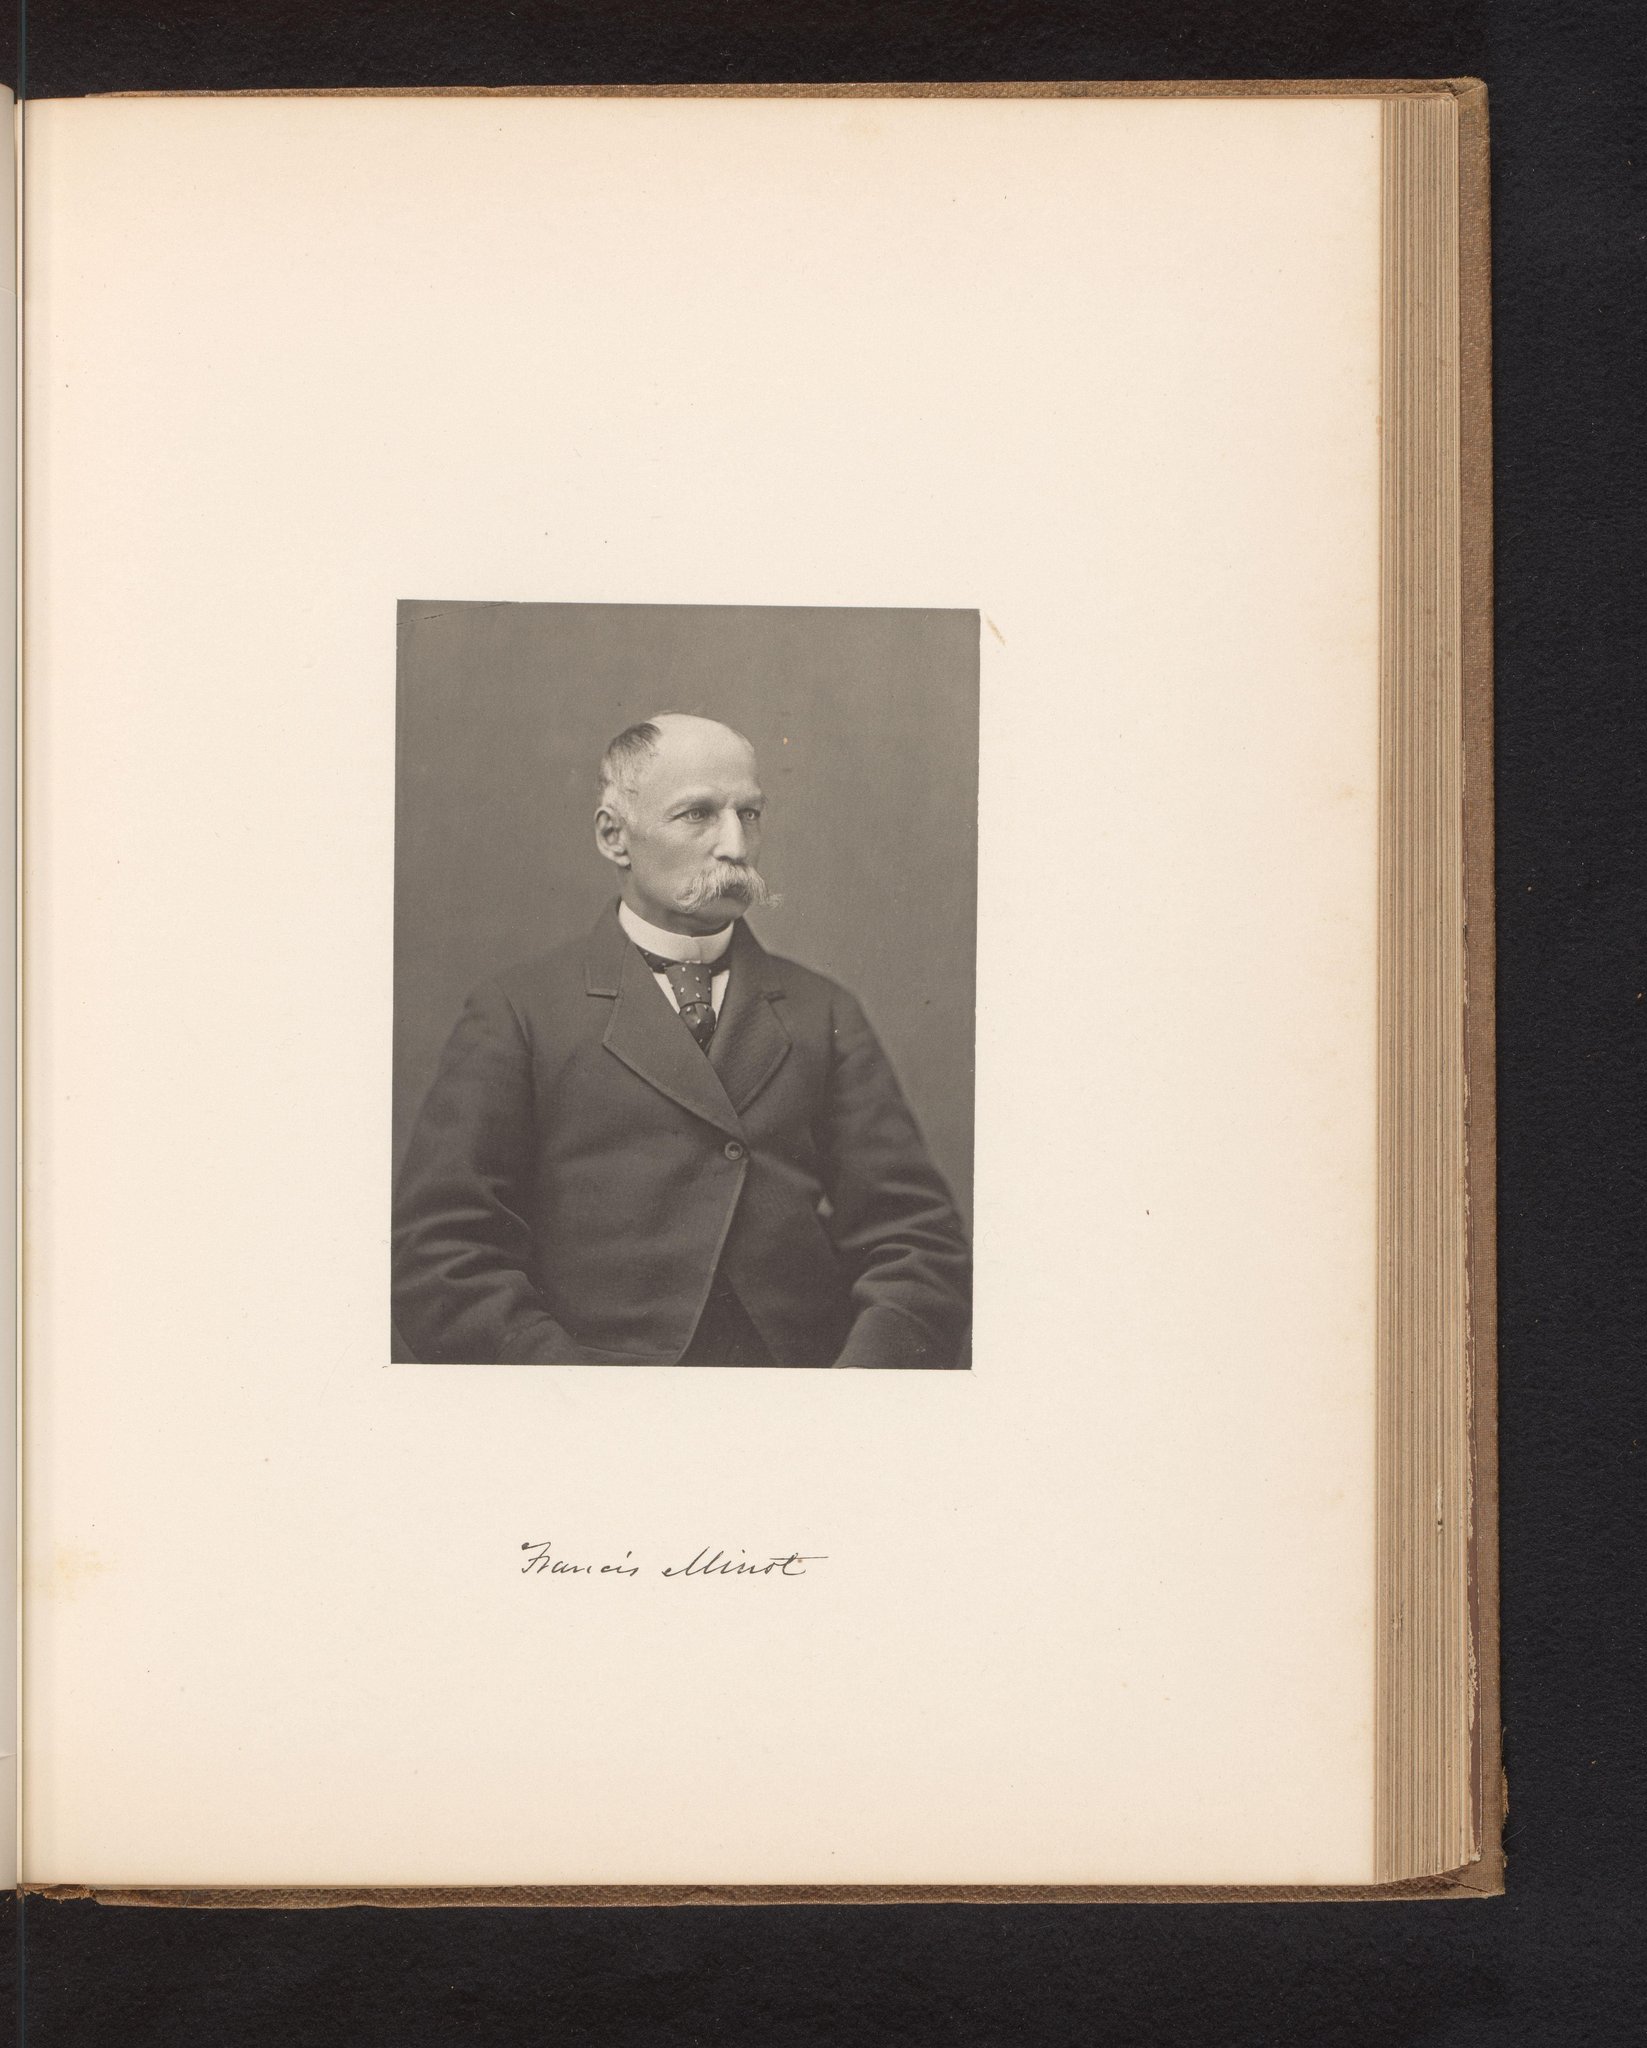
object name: photomechanical print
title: Francis Minot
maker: Anonymous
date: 1870-1875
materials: paper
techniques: photograph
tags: historical persons, physician, doctor, professor